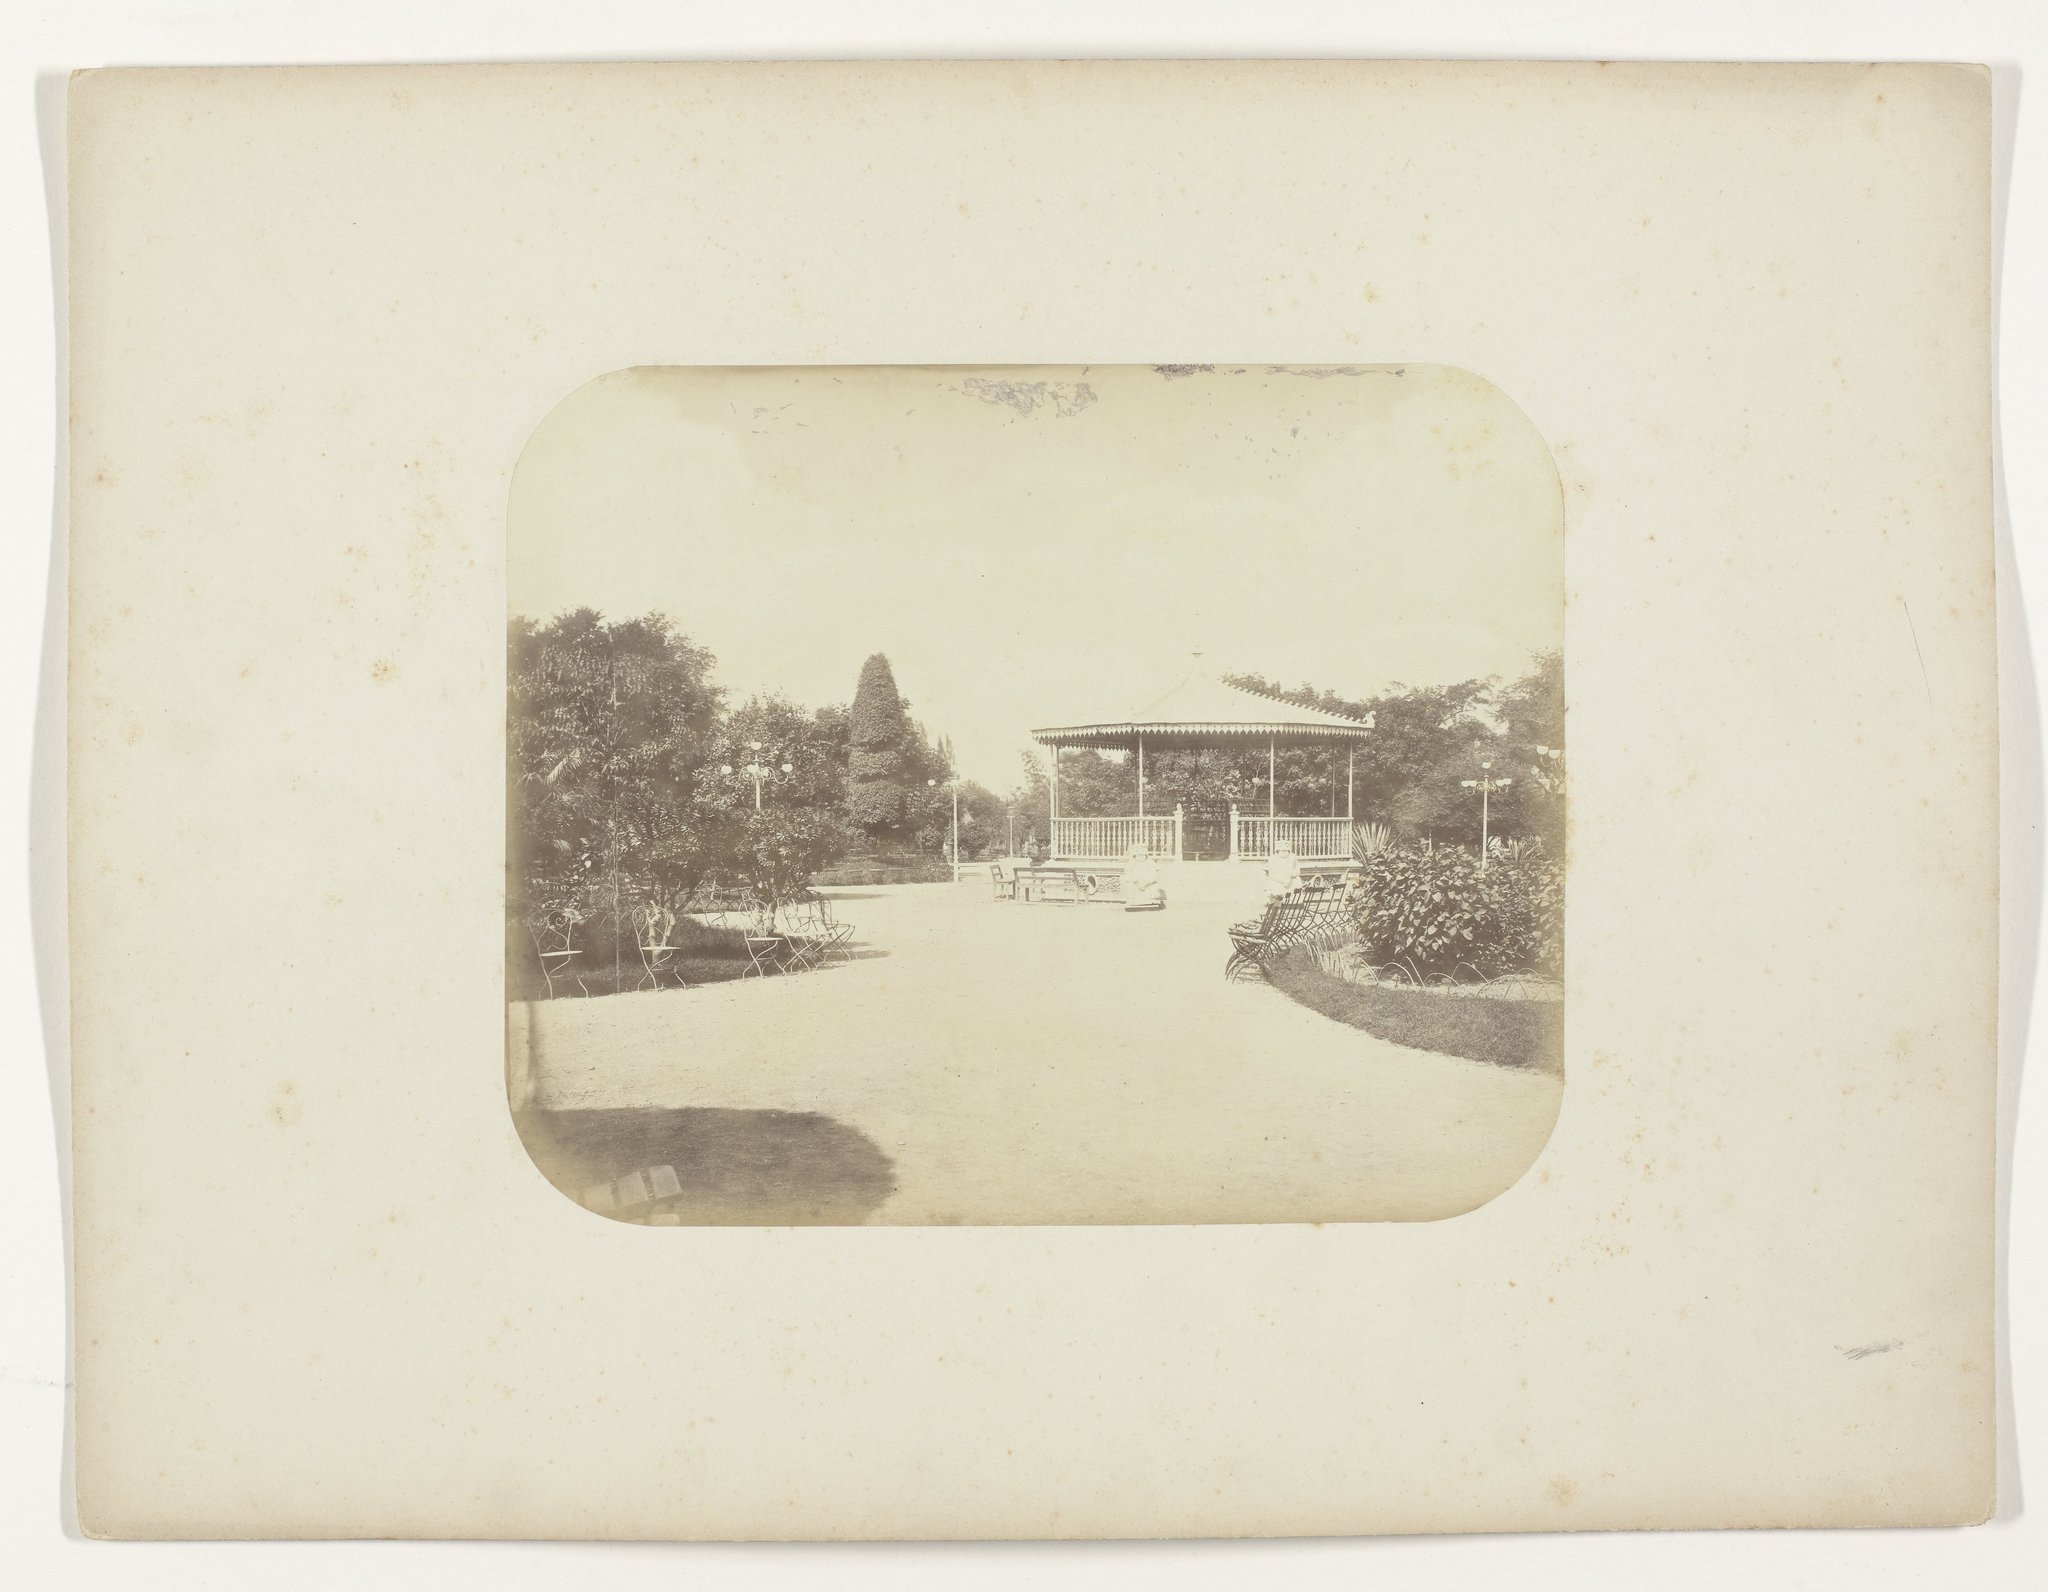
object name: photograph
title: Een kiosk in het stadspark van Surabaya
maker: herman salzwedel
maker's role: fotograaf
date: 1876-1884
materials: photographic support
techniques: albumen print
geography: surabaya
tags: utrecht, the hague, colonial system, public gardens, park, surabaya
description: Een kiosk in het stadspark van Surabaya met bij de opening twee Hindoe-beelden. Bij de kiosk staan links twee banken. Langs het pad staan vele stoeltjes en enkele lantaarnpalen. Onderdeel van het fotoalbum door de Soerabayasche Vereeniging van Suikerfabrikanten aangeboden aan Frederik Beyerinck, resident van Soerabaja.